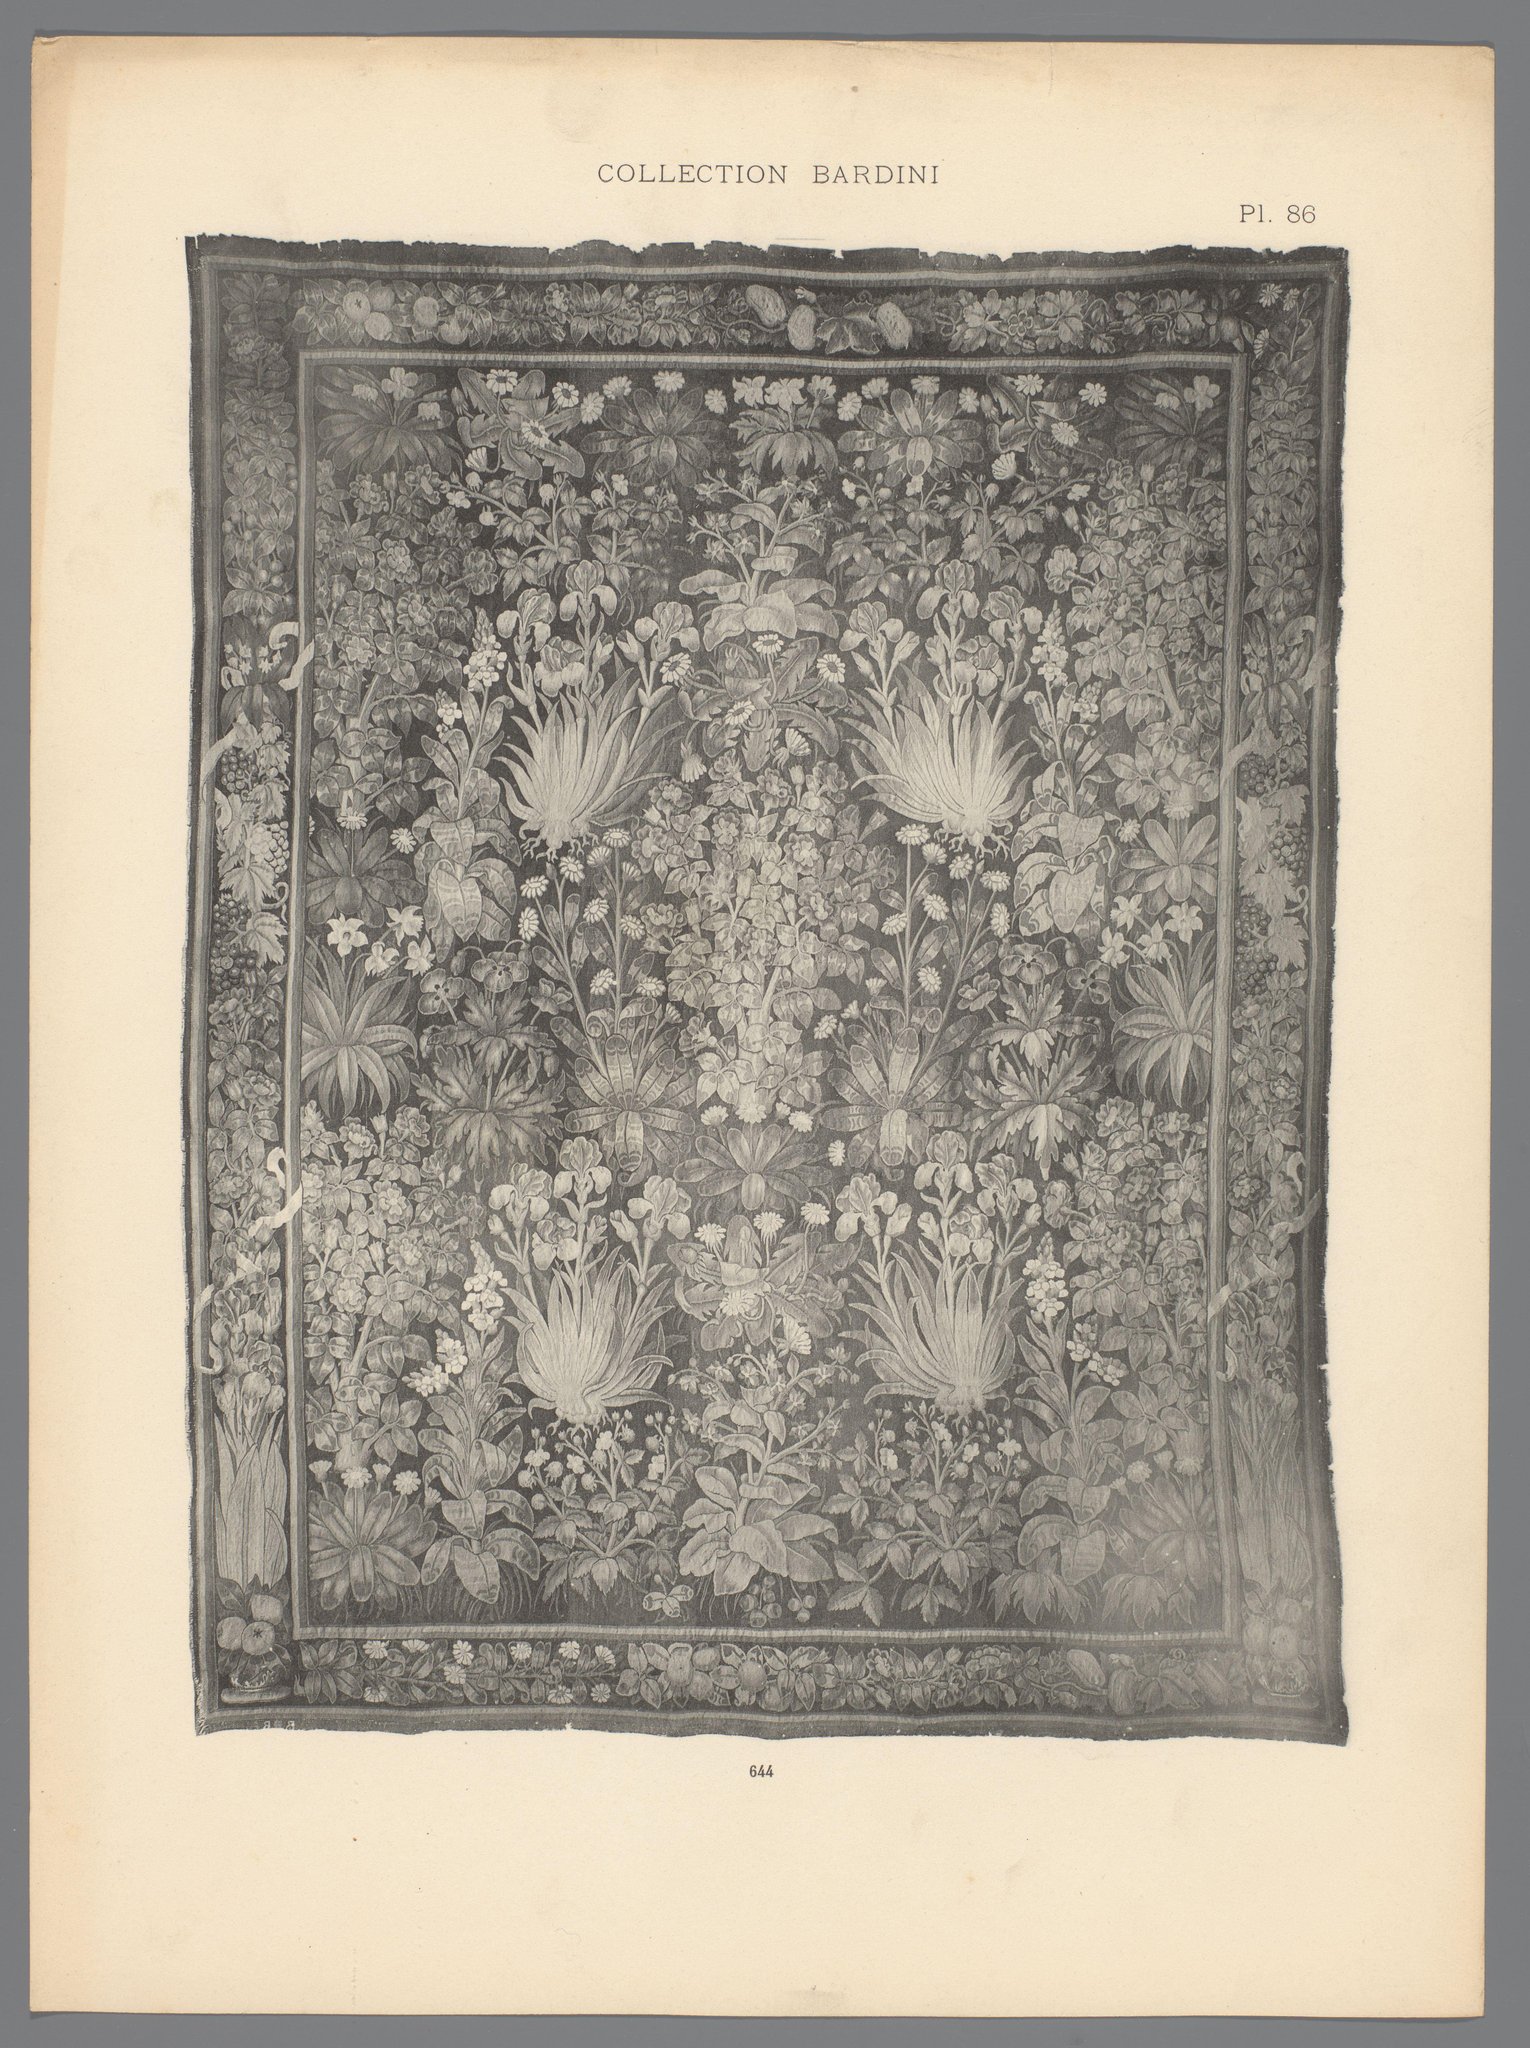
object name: photomechanical print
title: Wandtapijt met bloemen en bladeren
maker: Anonymous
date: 1875-1930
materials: paper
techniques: photograph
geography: florence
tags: flowers, tapestry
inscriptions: number: ‘Pl. 86’